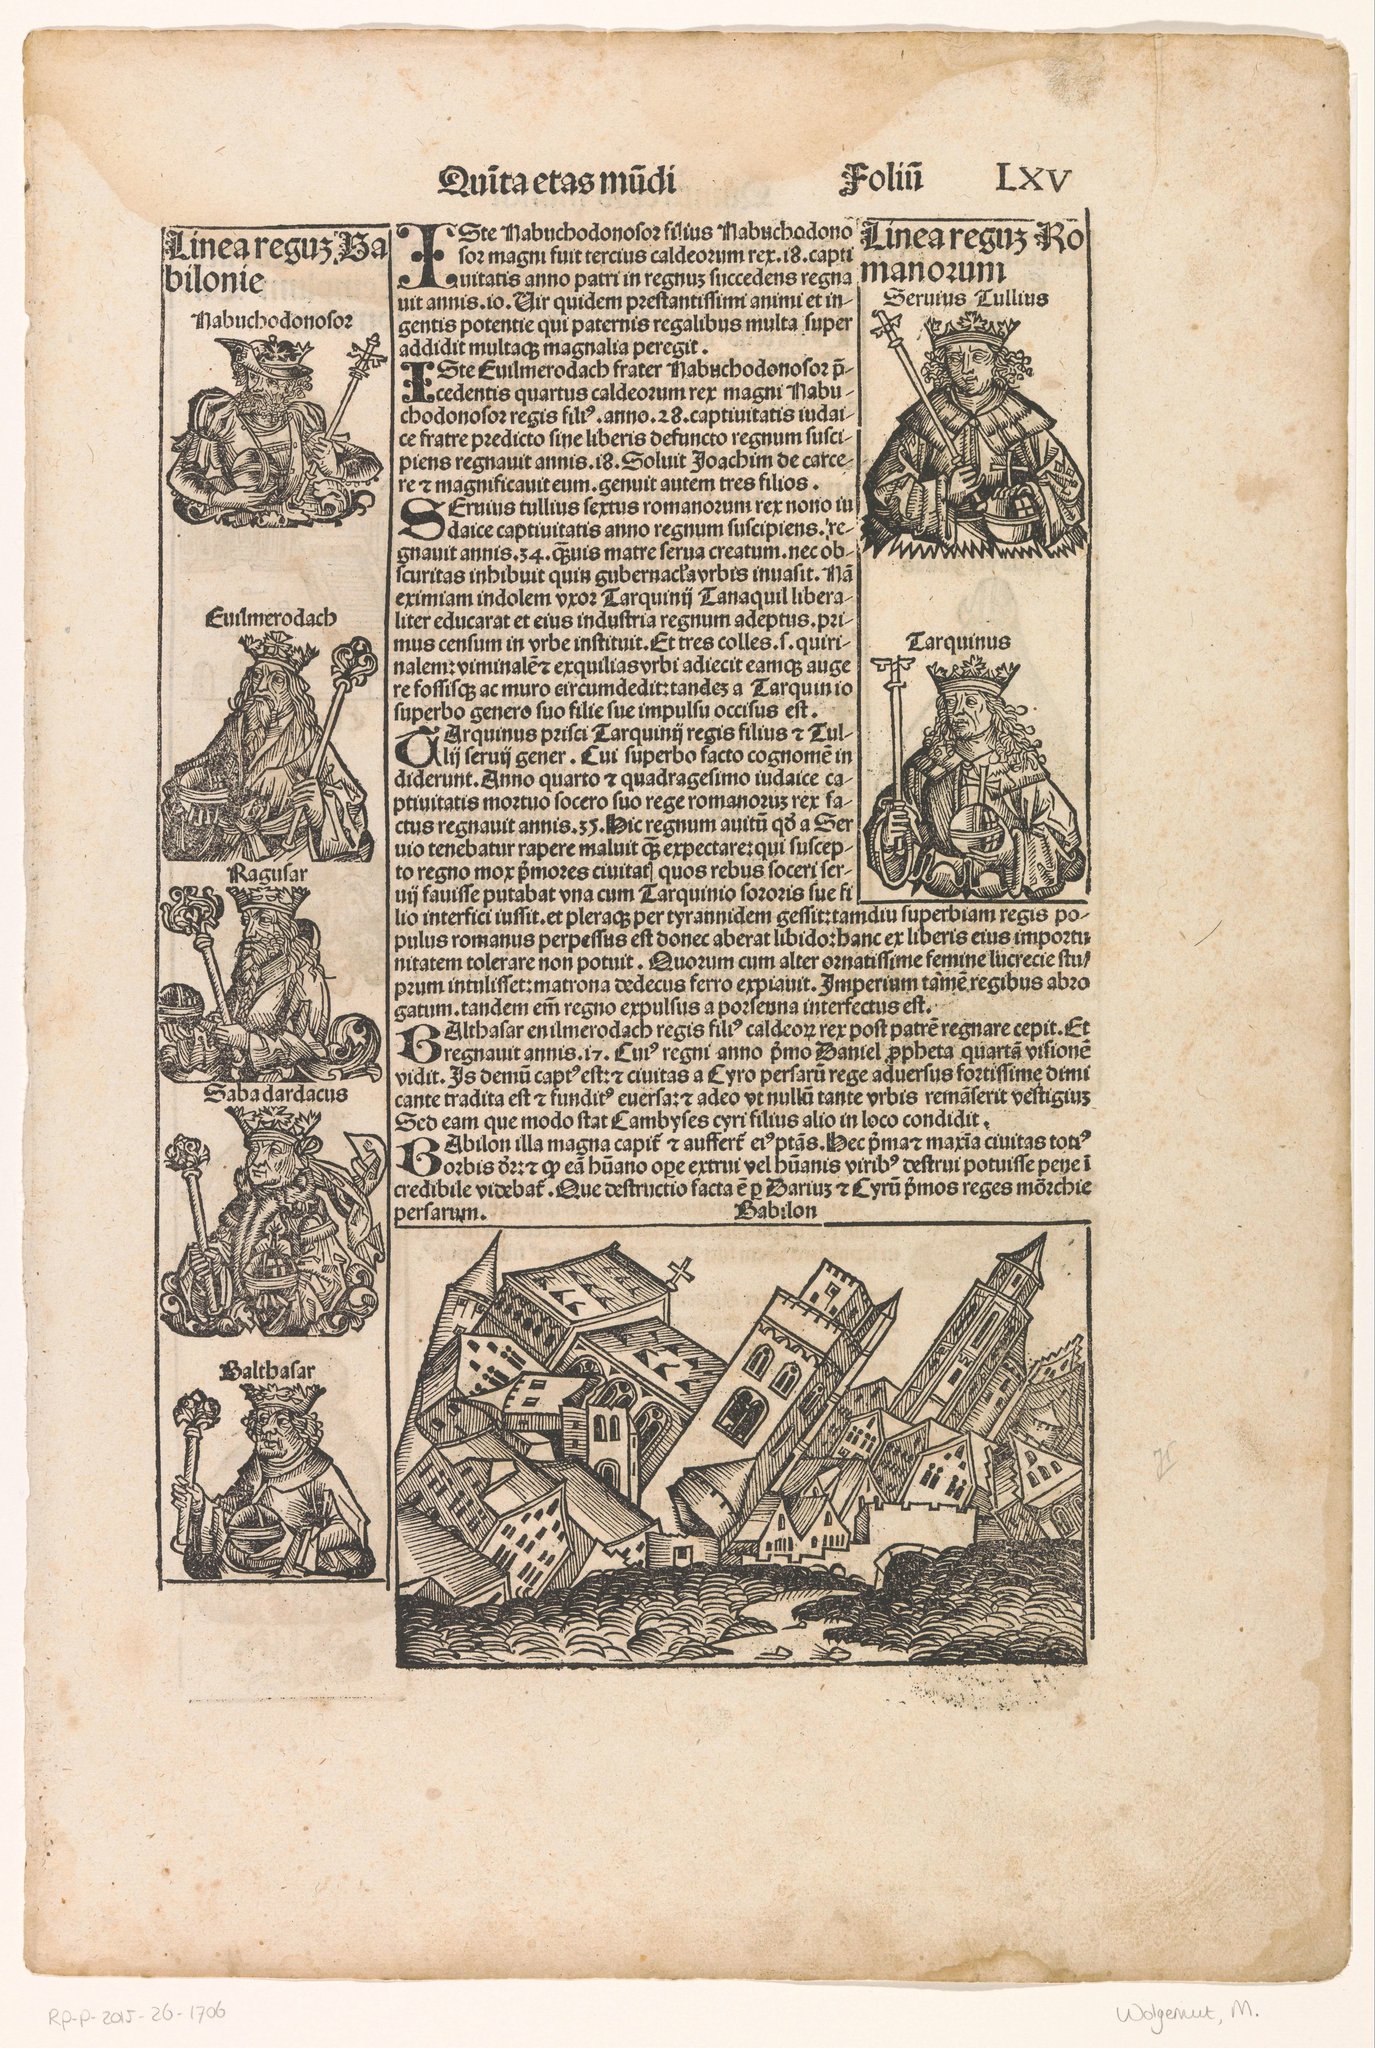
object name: print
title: Bladzijde uit de Neurenbergkroniek van Schedel, folio 45r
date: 1493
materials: paper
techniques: letterpress printing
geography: nuremberg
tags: babylon (one of the four world empires)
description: De Neurenbergkroniek van Hartmann Schedel is bekend om zijn vele illustraties. Voor de 1804 houtsneden werden 441 verschillende houtblokken gemaakt. Vele houtblokken werden dus meer dan eens gebruikt. Titels bij de figuren identificeren de voorstelling of de voorgestelde personen. Deze pagina is afkomstig uit de Latijnse uitgave van 1493.